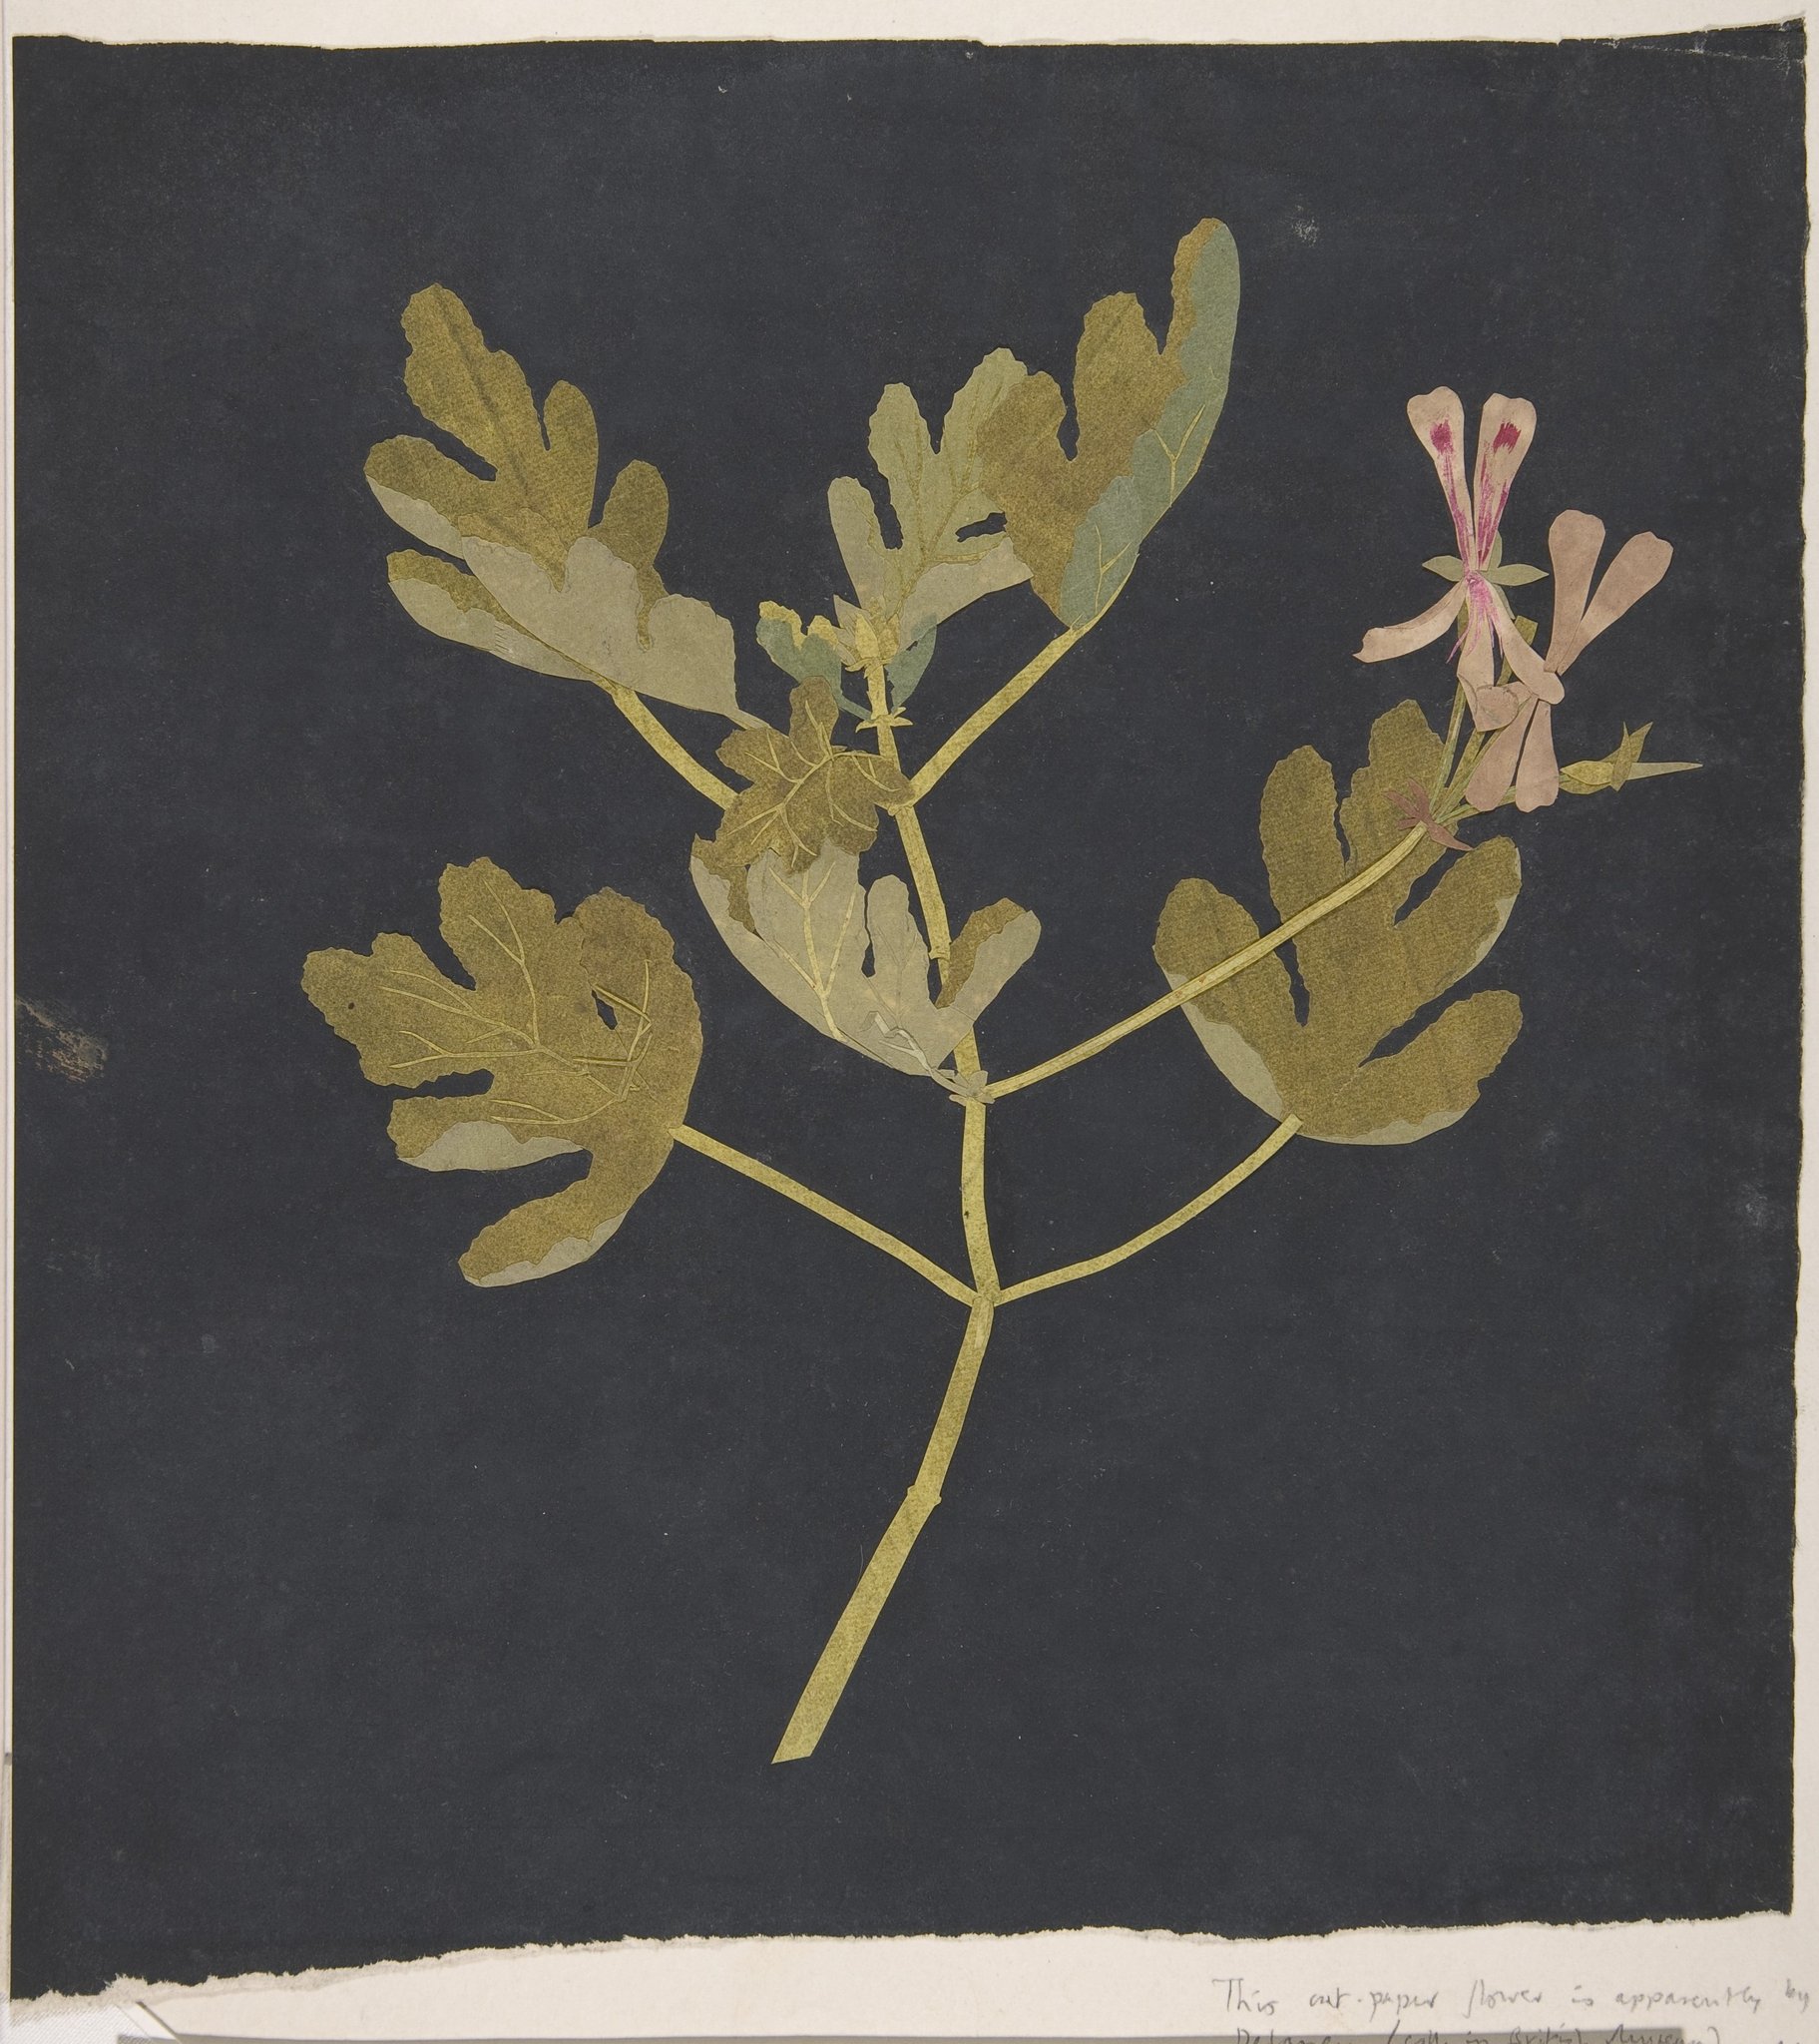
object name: cut paper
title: Botanical Study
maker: mary delany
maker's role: artist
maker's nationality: british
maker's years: 1700-1788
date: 1772-1782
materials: paper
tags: plants